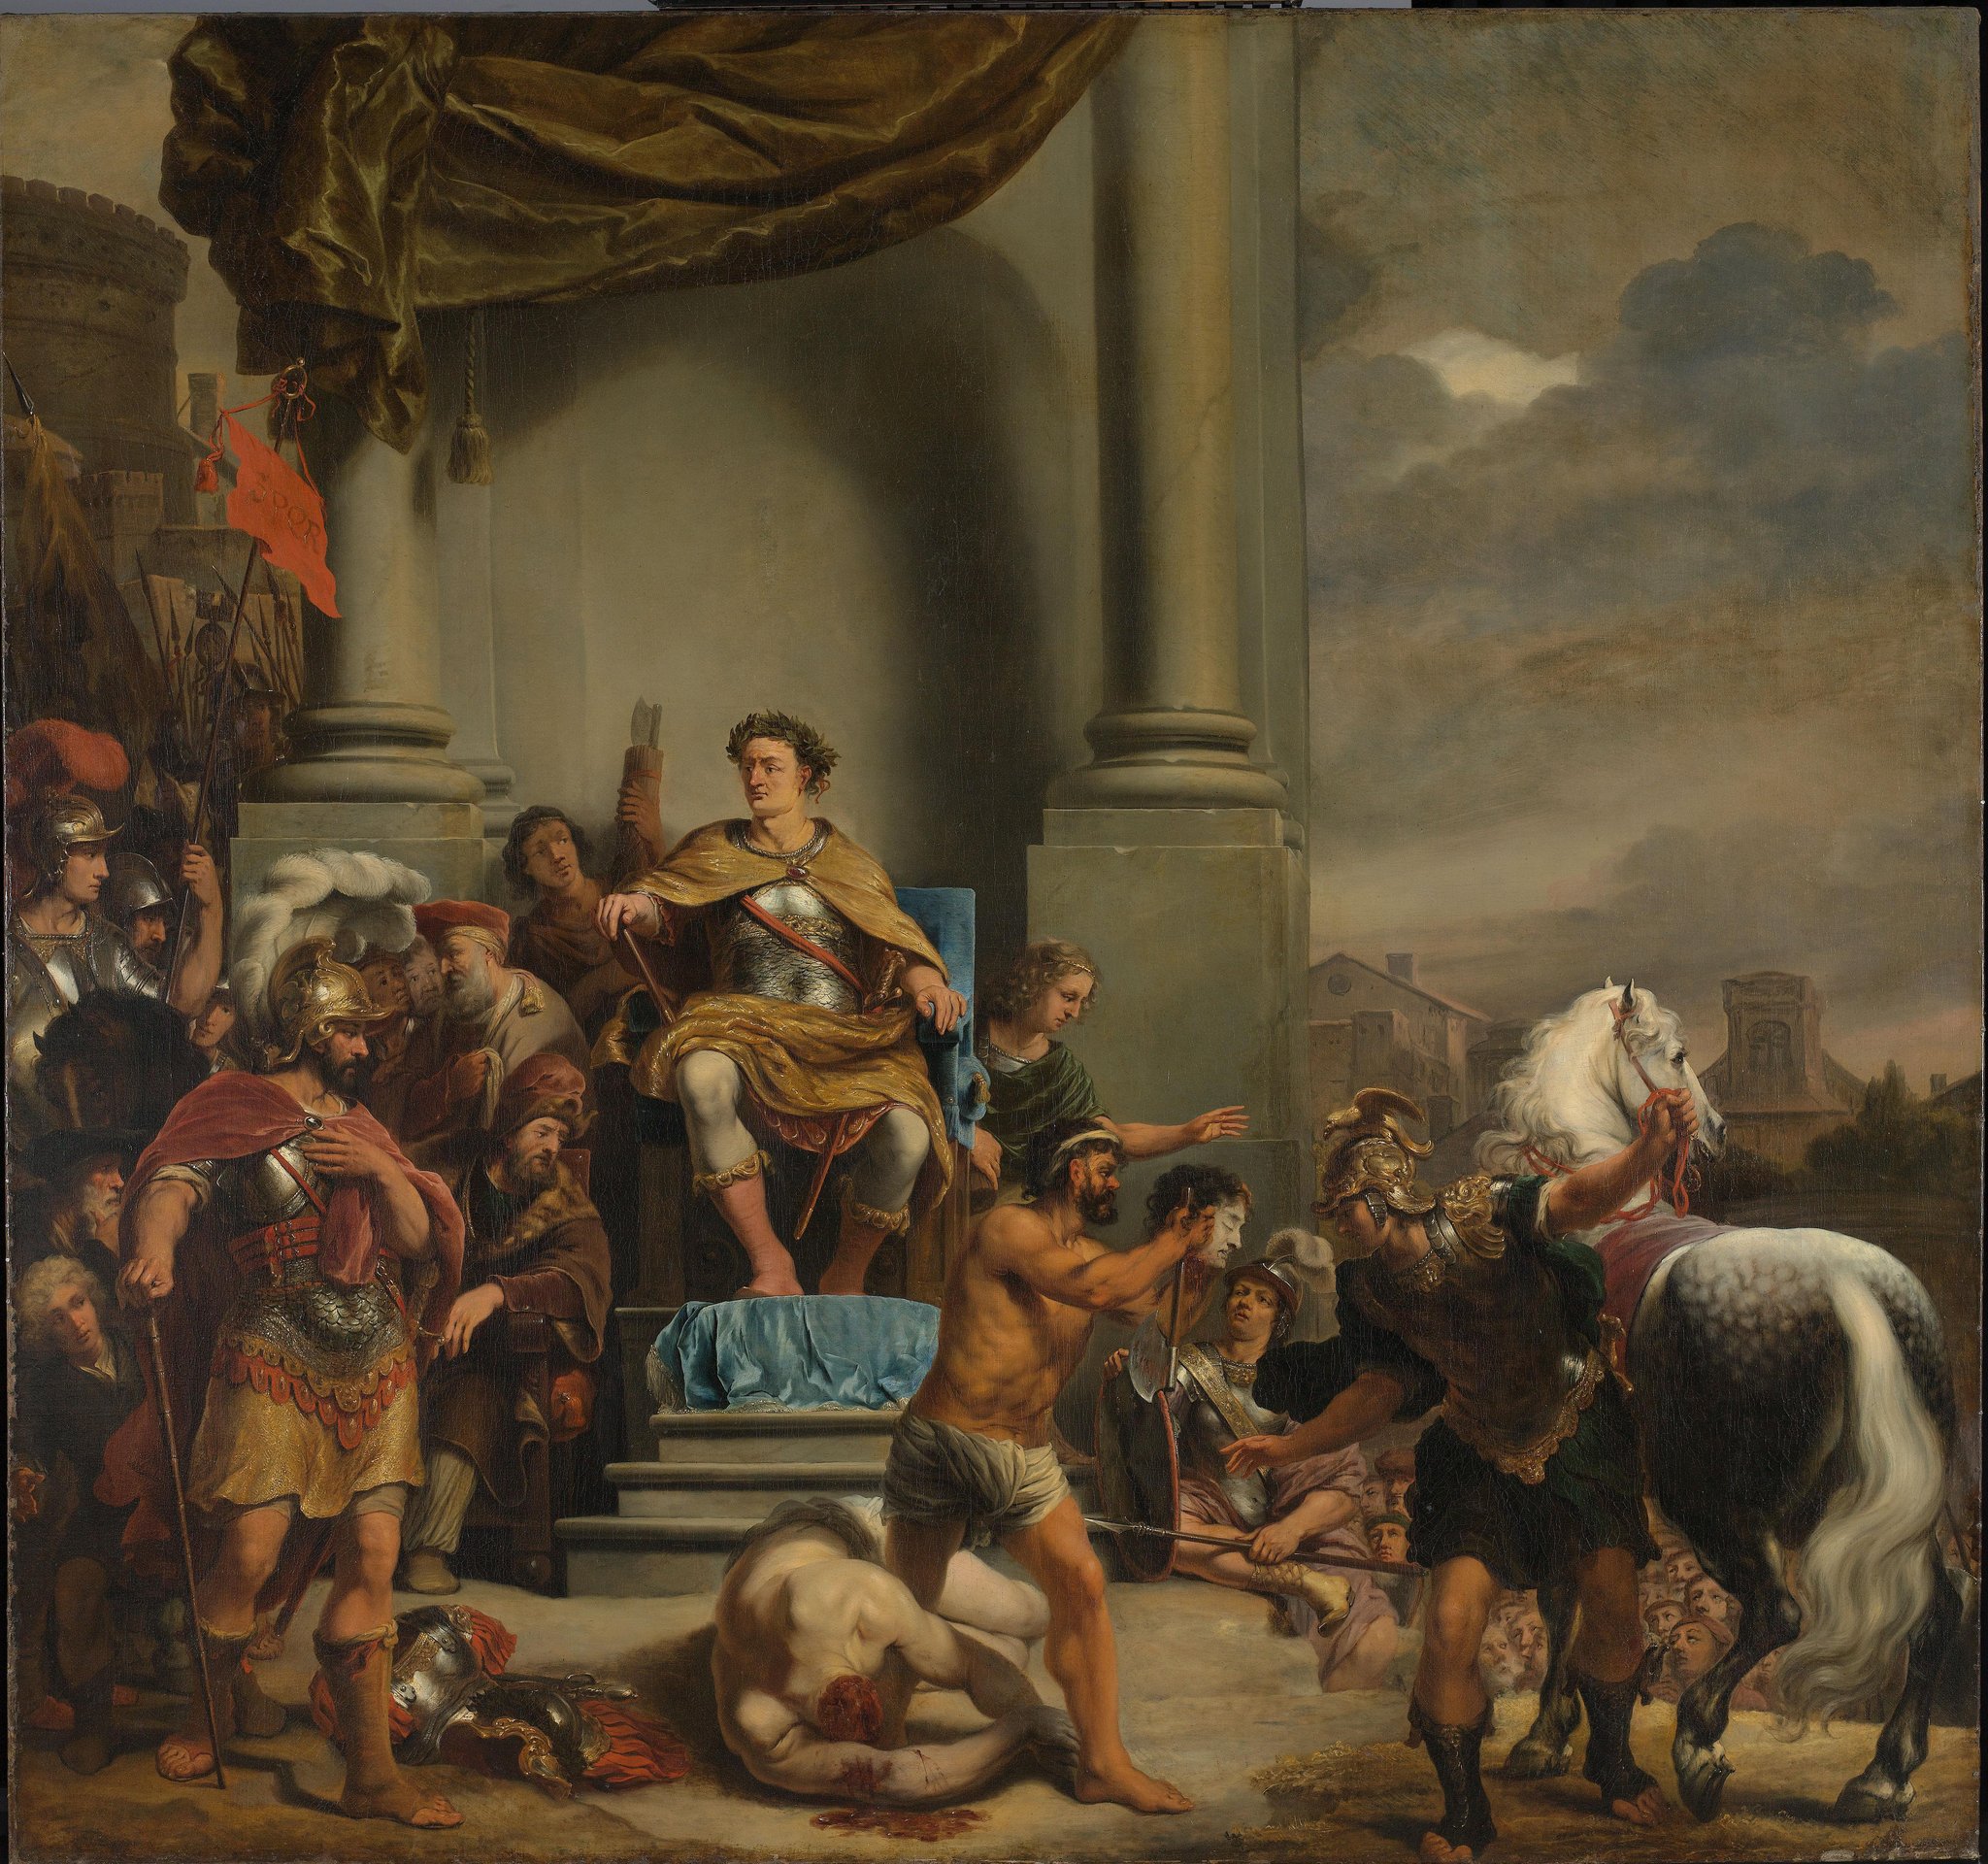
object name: painting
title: Consul Titus Manlius Torquatus Orders the Beheading of his Son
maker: ferdinand bol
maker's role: draughtsman, painter, print maker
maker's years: 1616-1680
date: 1661-1663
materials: canvas, oil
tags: torquatus has his son beheaded because he has fought an enemy in single combat against the strict orders of his father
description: This picture was painted for the headquarters of the Admiralty of Amsterdam. It represents a story from Roman times in which a consul ondemns his son to be beheaded for ignoring a command. The Admiralty intended this image to proclaim that insubordination would be severely punished. It also reminded officers that they must always remain impartial.